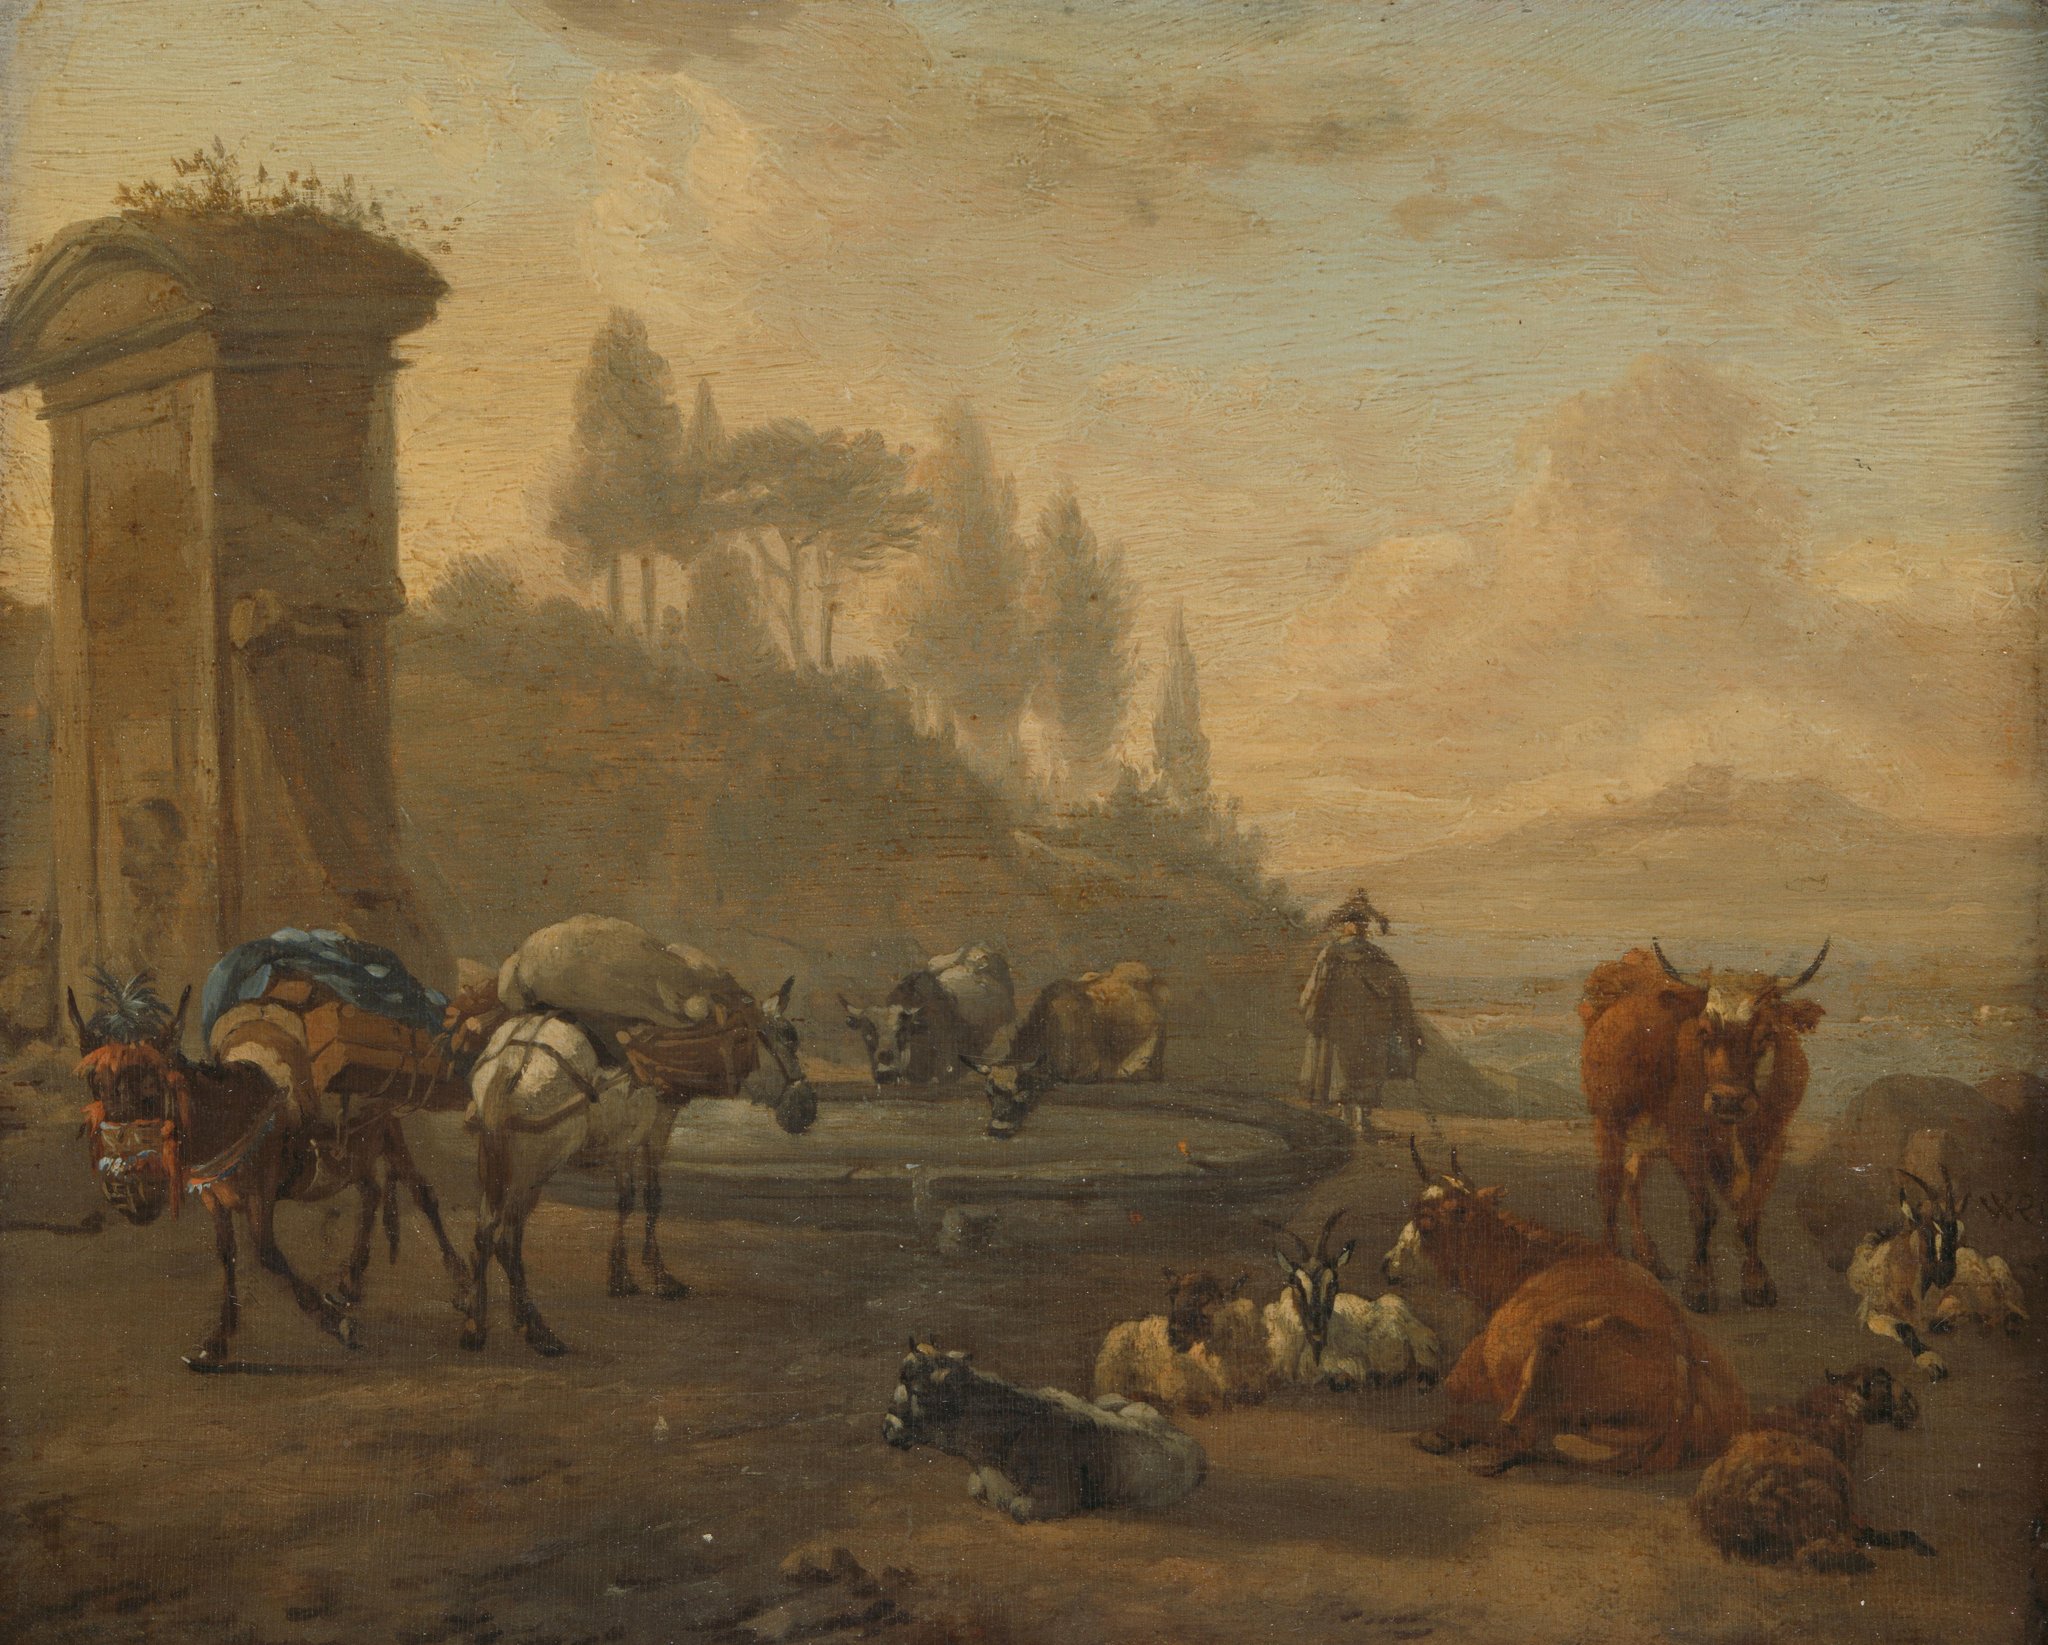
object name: painting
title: Livestock by a Fountain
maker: willem romeyn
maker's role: draughtsman, painter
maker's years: 1624-1694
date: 1650-1694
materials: oil, panel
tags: harbour, well, utilitarian, public pump or water fountain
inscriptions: signature: ‘WR’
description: Kudde bij een fontein. Italiaans landschap met reizigers en vee die rusten bij een fontein. Links staan twee bepakte muilezels. Pendant van SK-A-338.